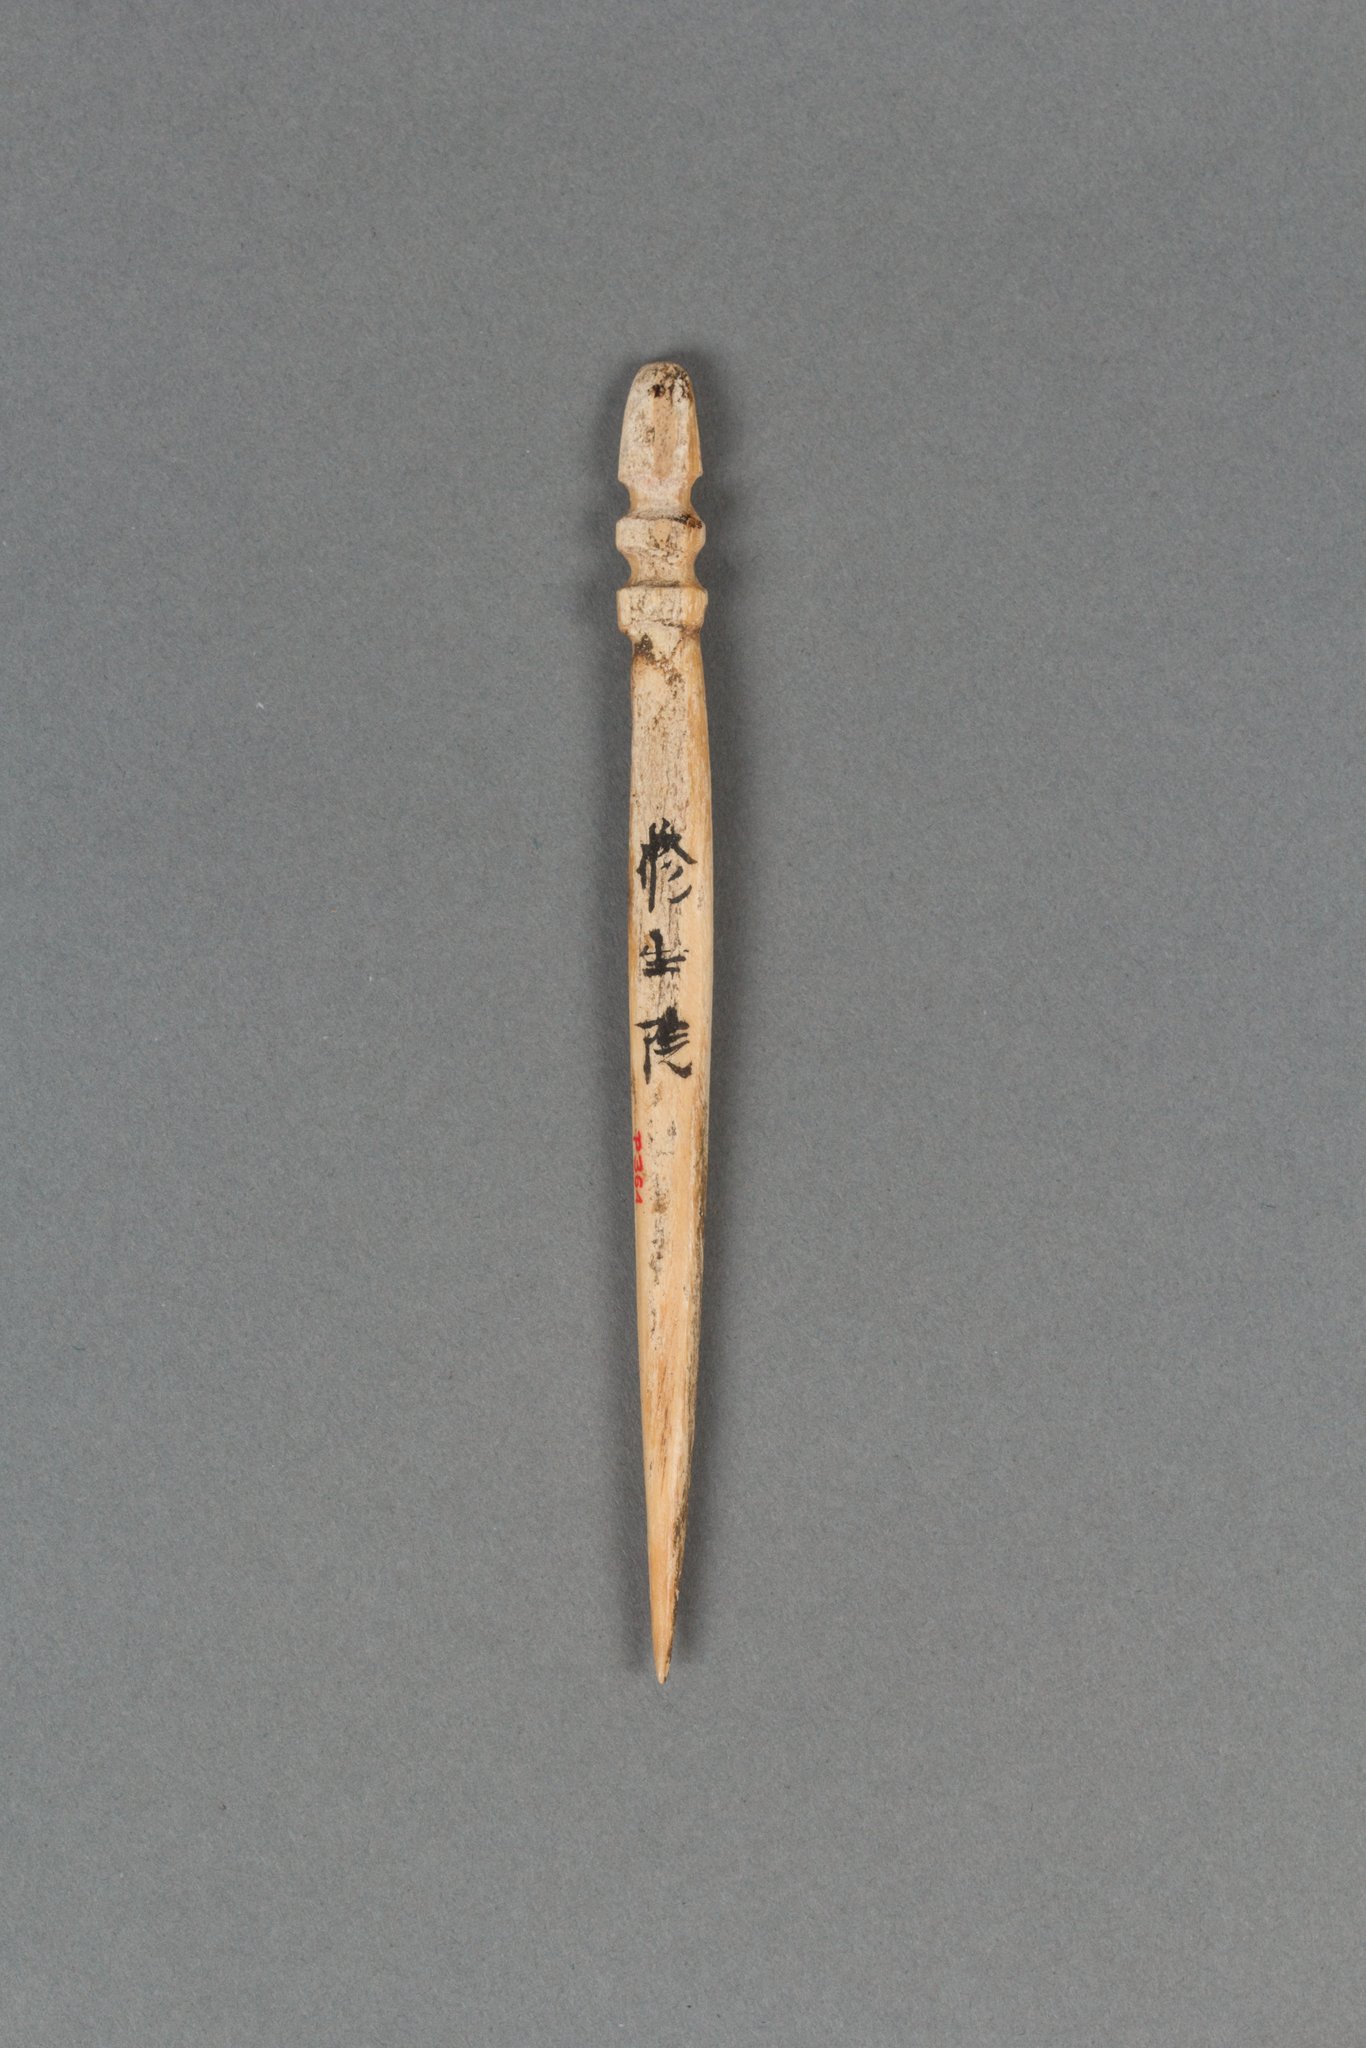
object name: hairpin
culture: japanese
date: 1200-200 BCE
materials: bone